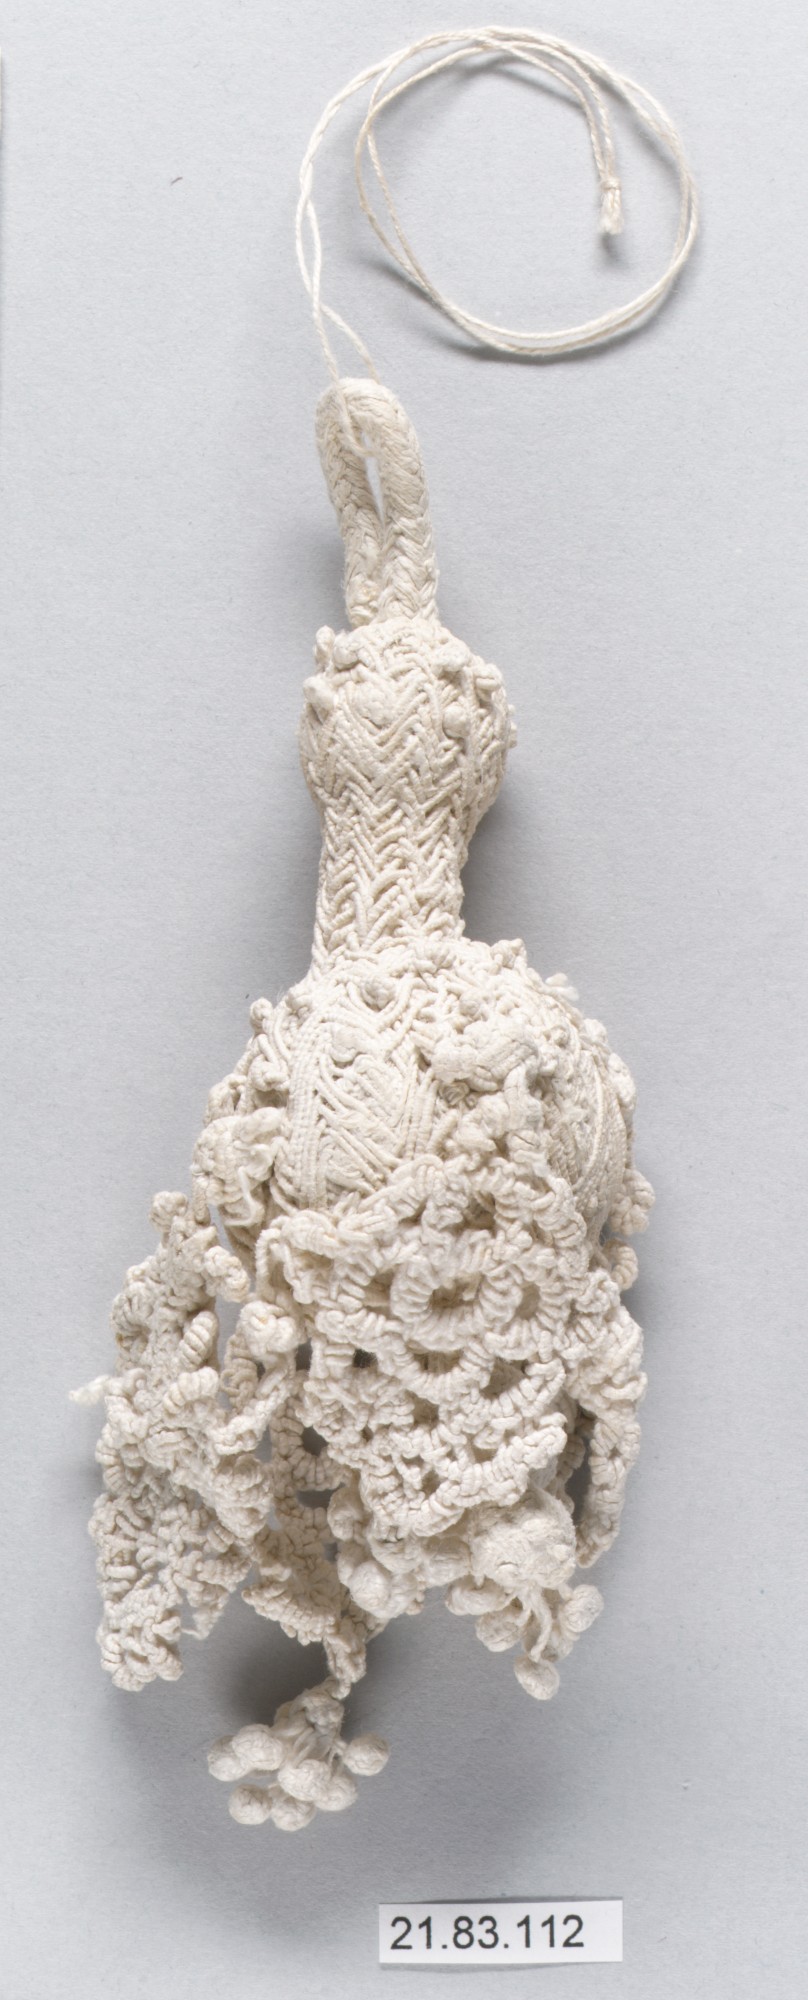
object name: tassel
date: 1601-1700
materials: linen